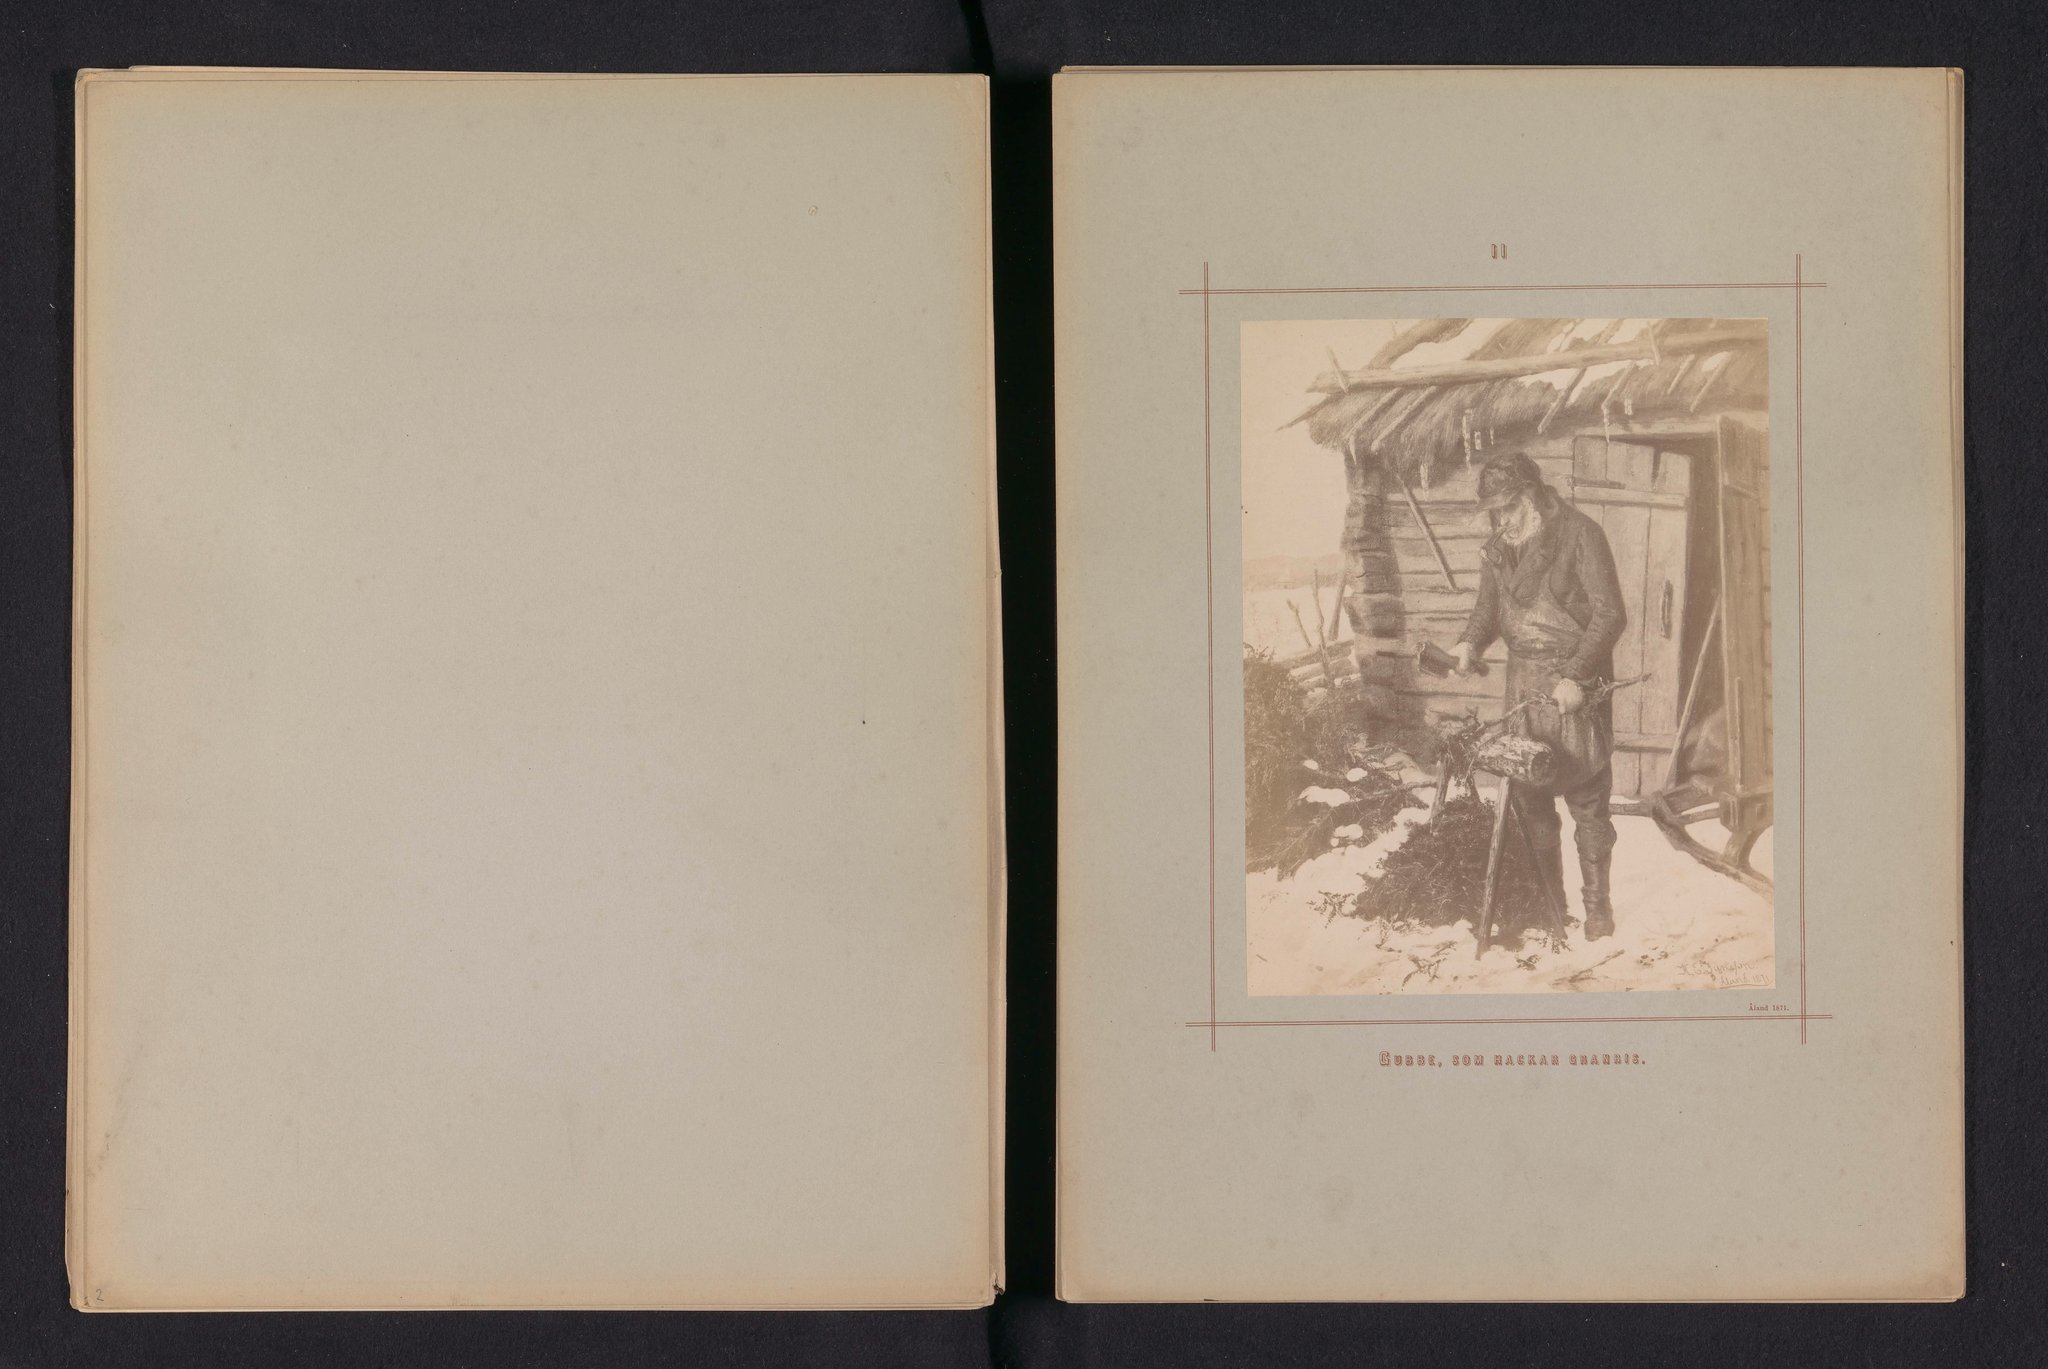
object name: page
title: Fotoreproductie van een schilderij door Karl Emanuel Jansson, voorstellende een oude man die hout van sparren hakt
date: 1871-1880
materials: photographic support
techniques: albumen print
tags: woodcutting, woodcutter ~ forestry, old man, picture, painting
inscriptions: inscription: ‘Åland 1871’, number: ‘II’